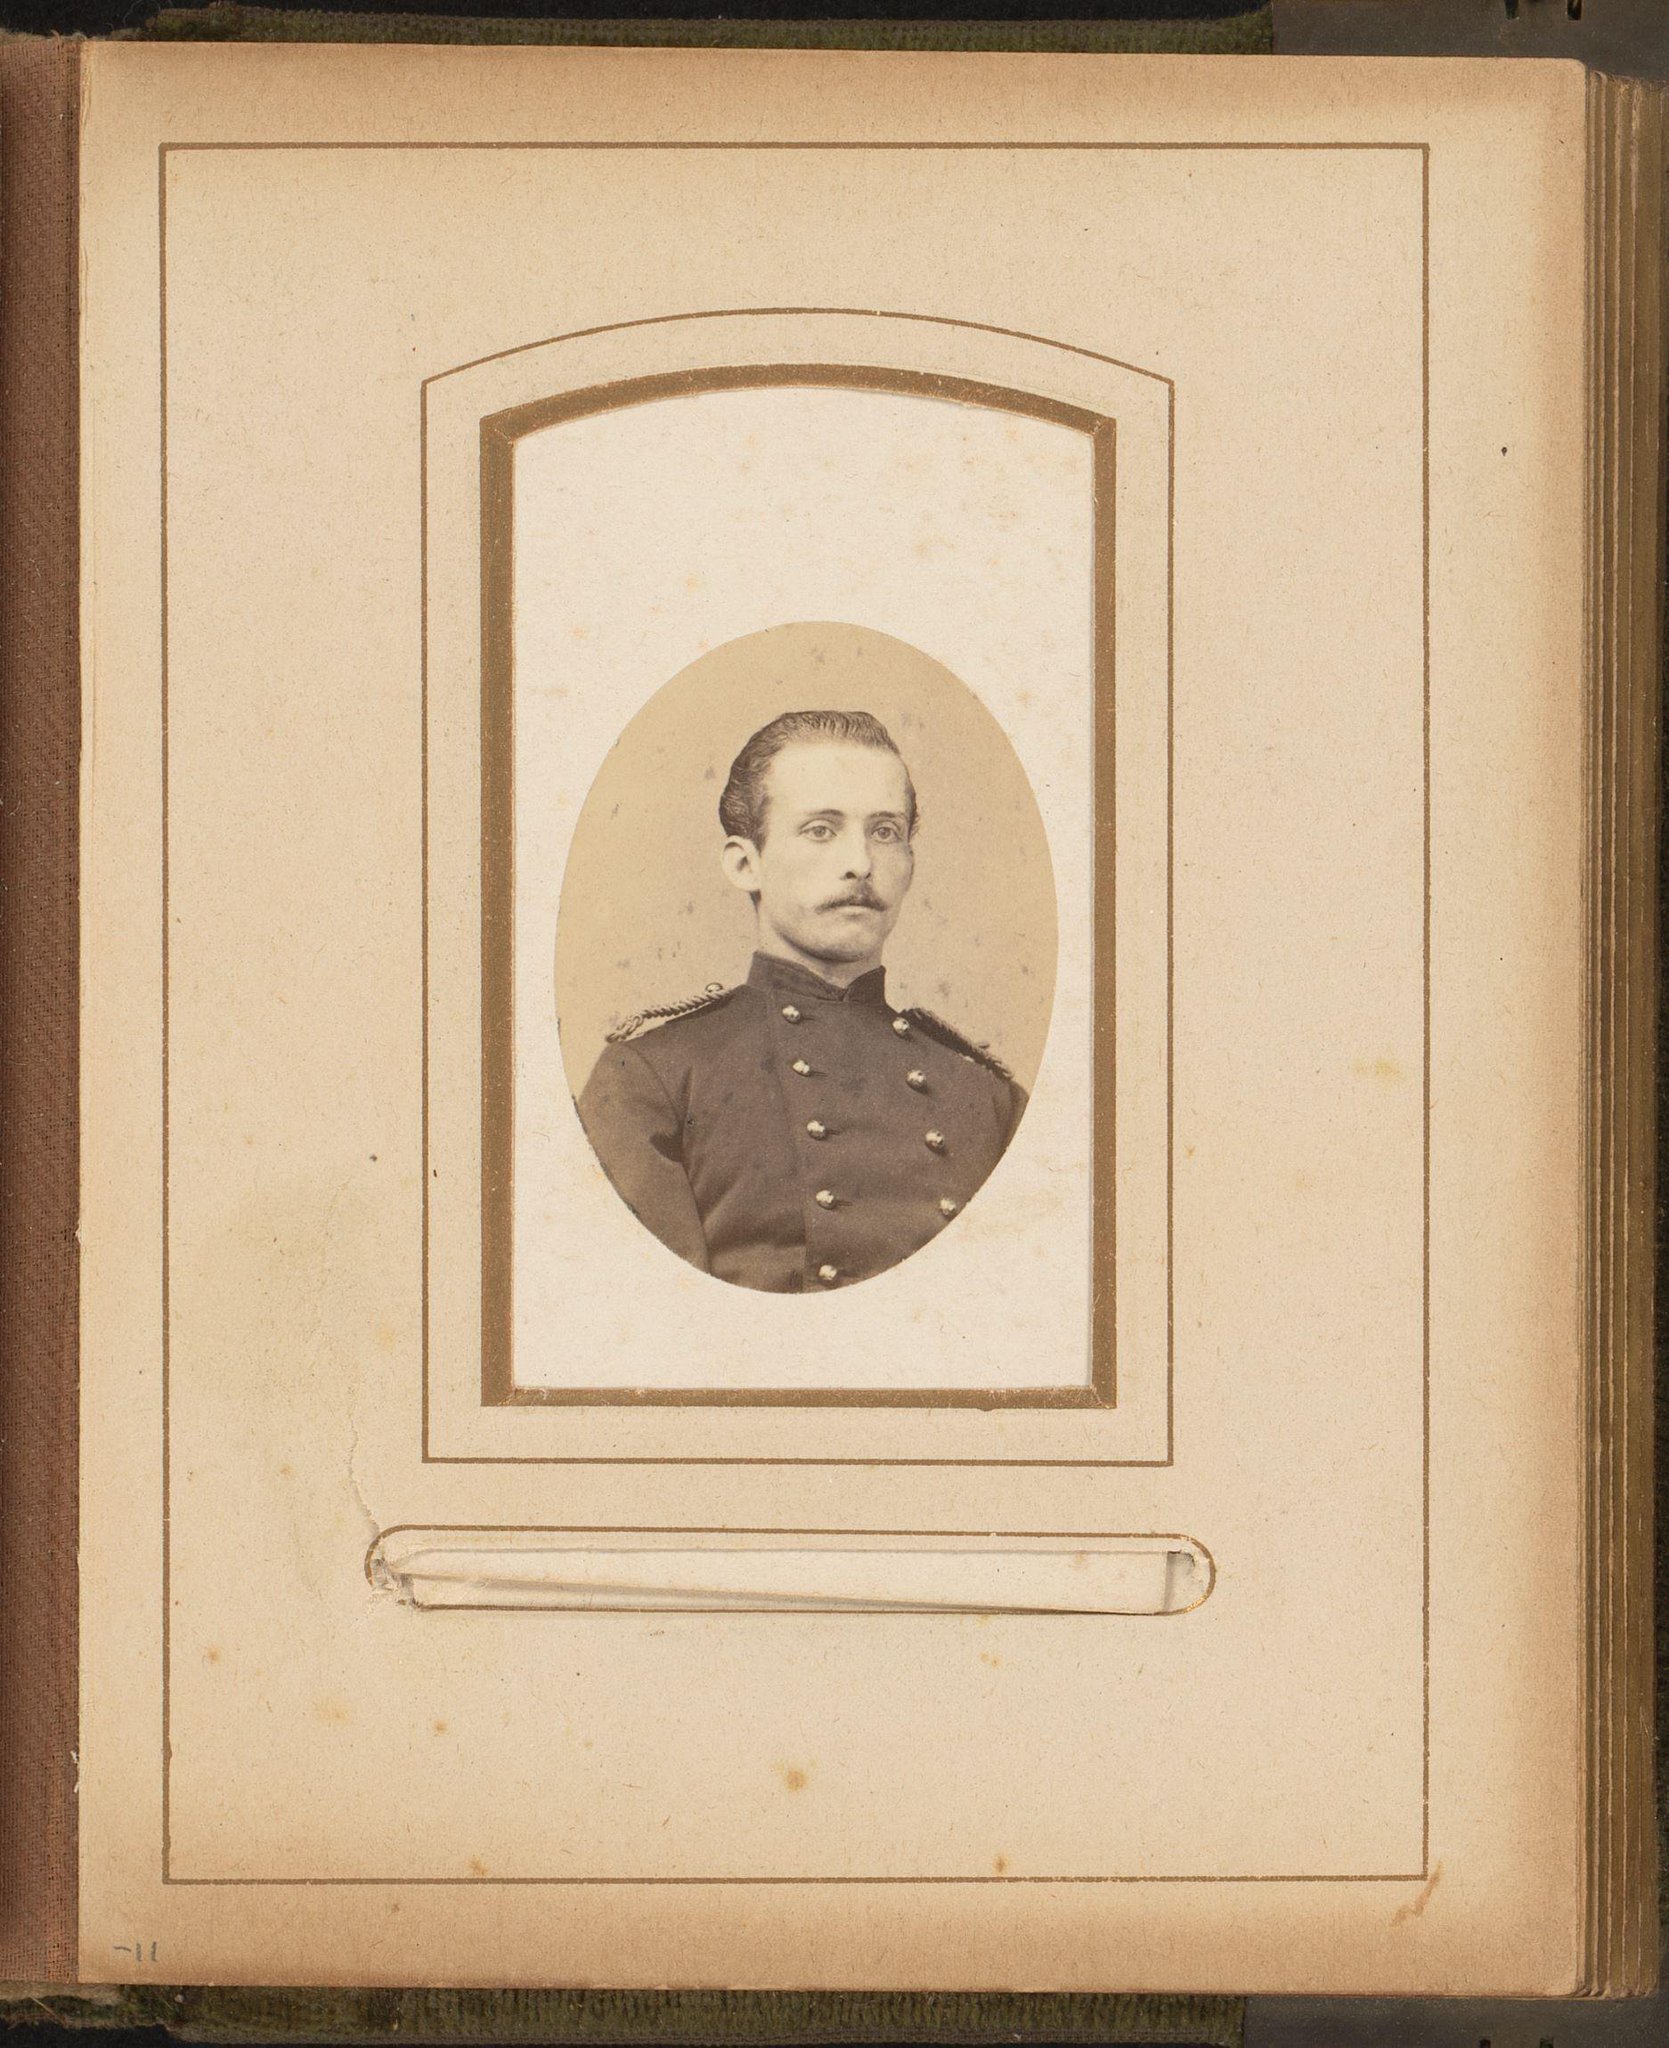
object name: carte de visite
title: Portret van een man in militair uniform, mogelijk lid van de familie Beucker Andreae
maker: Anonymous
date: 1854-1885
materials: cardboard, paper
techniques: albumen print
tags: adult man, anonymous historical person portrayed, (military) uniforms